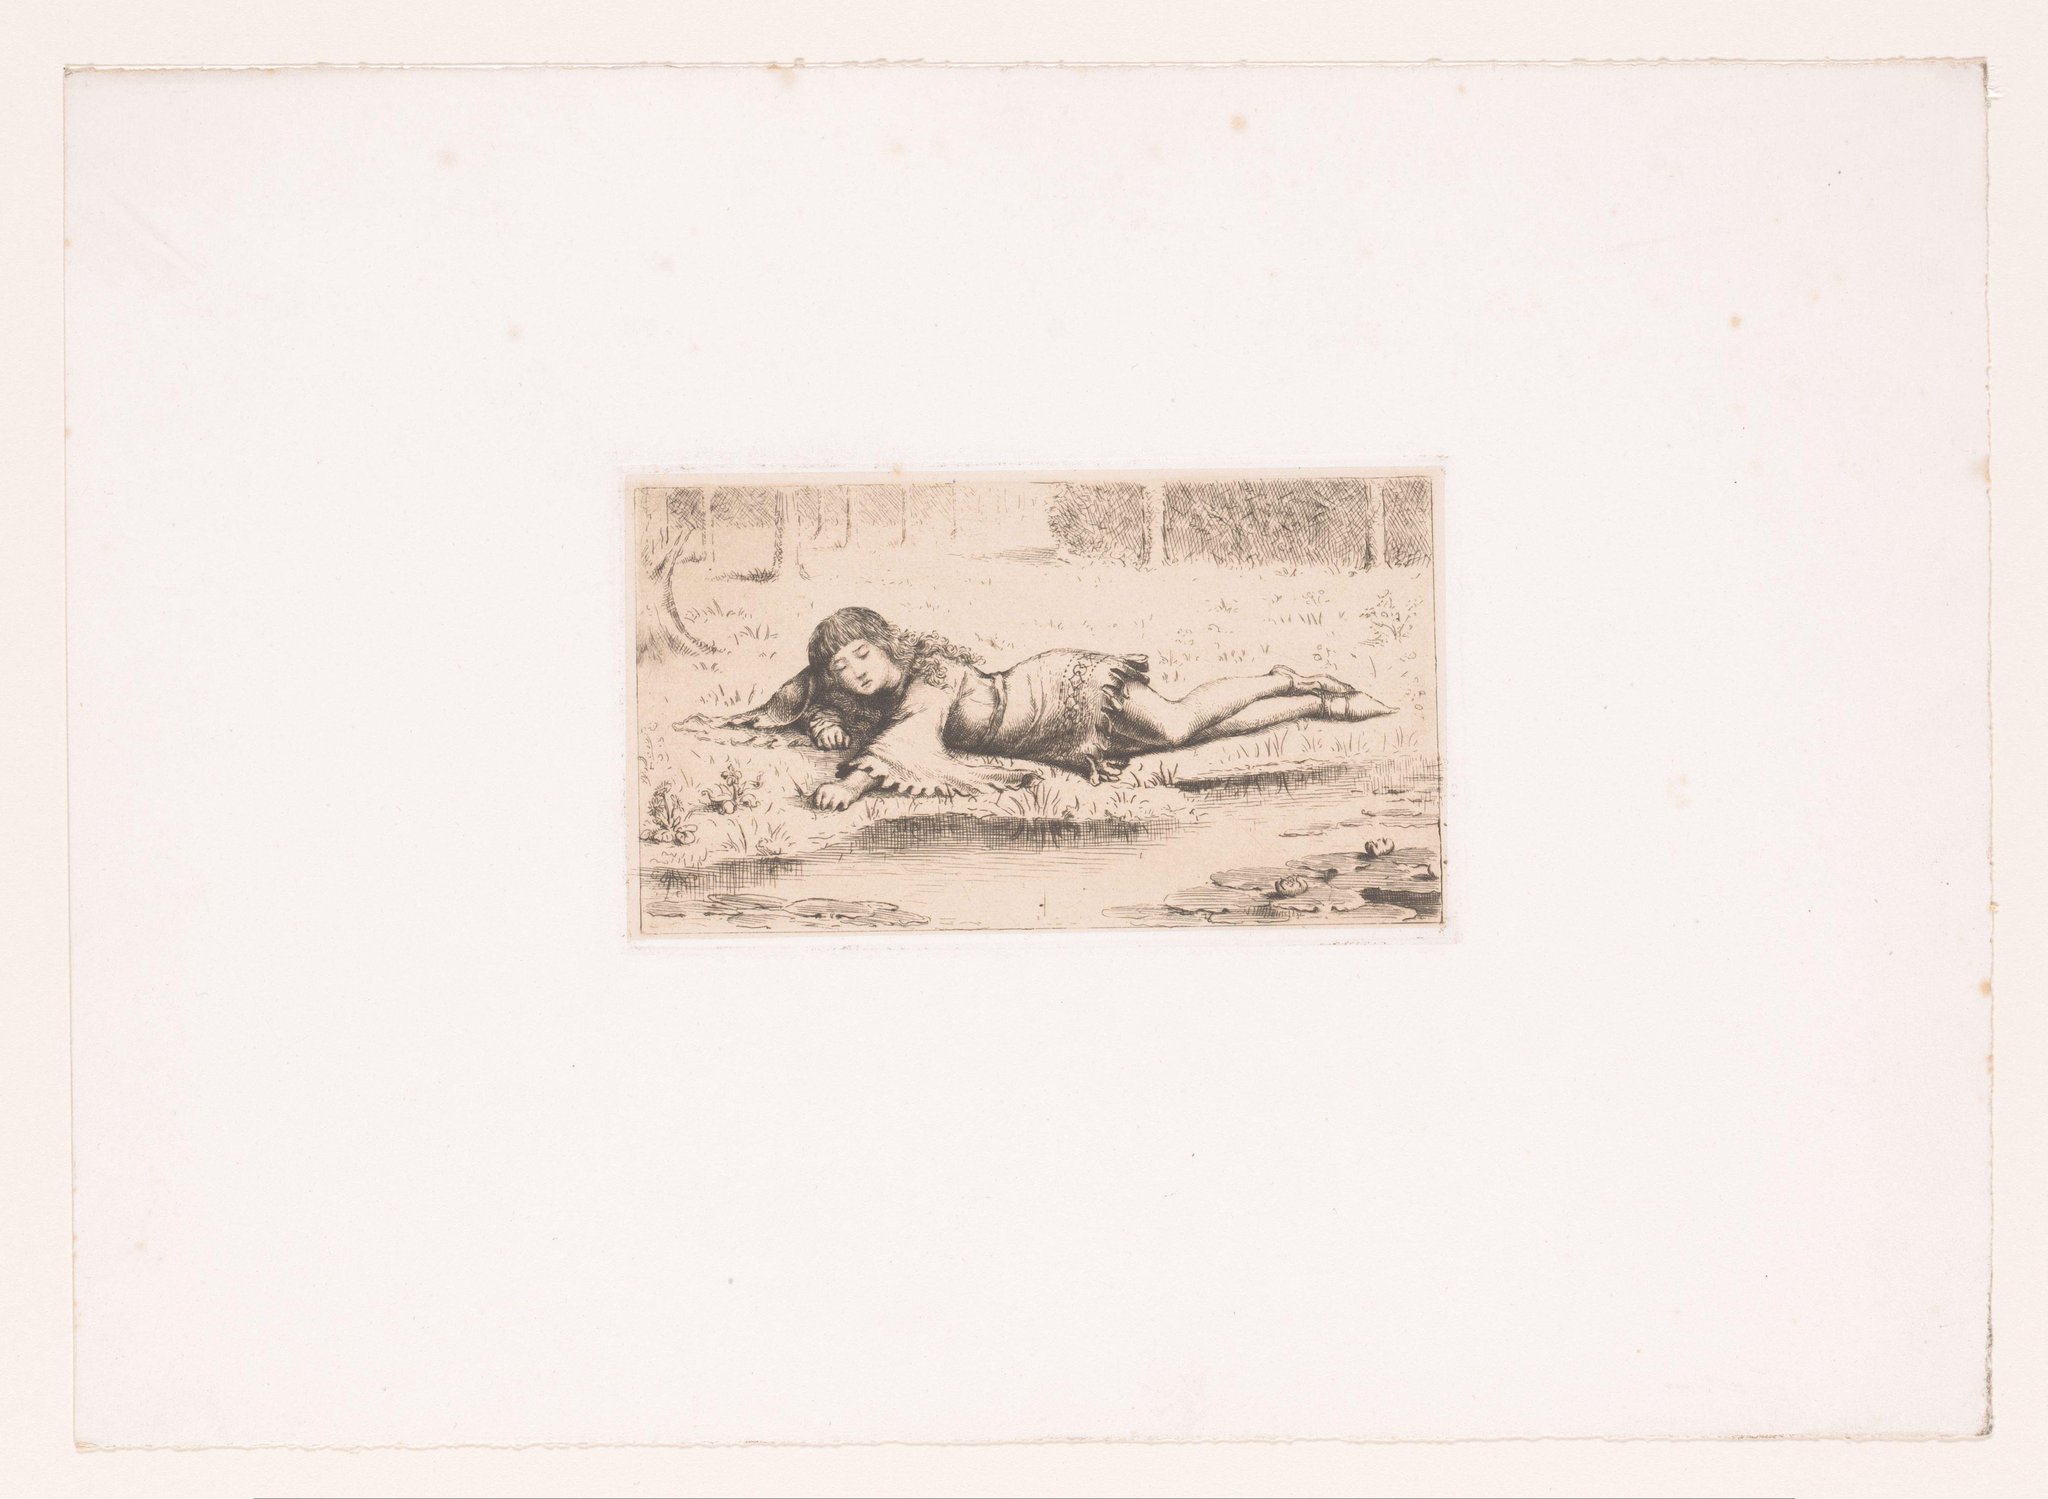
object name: print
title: Jongeling in middeleeuwse kleding ligt bij een meer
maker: jean-baptiste anthony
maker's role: painter, print maker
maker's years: 1854-1930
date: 1864-1909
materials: paper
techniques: drypoint, etching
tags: youth, adolescent, sleeping on the ground - bb - out of doors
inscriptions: collector's mark: Lugt 2228